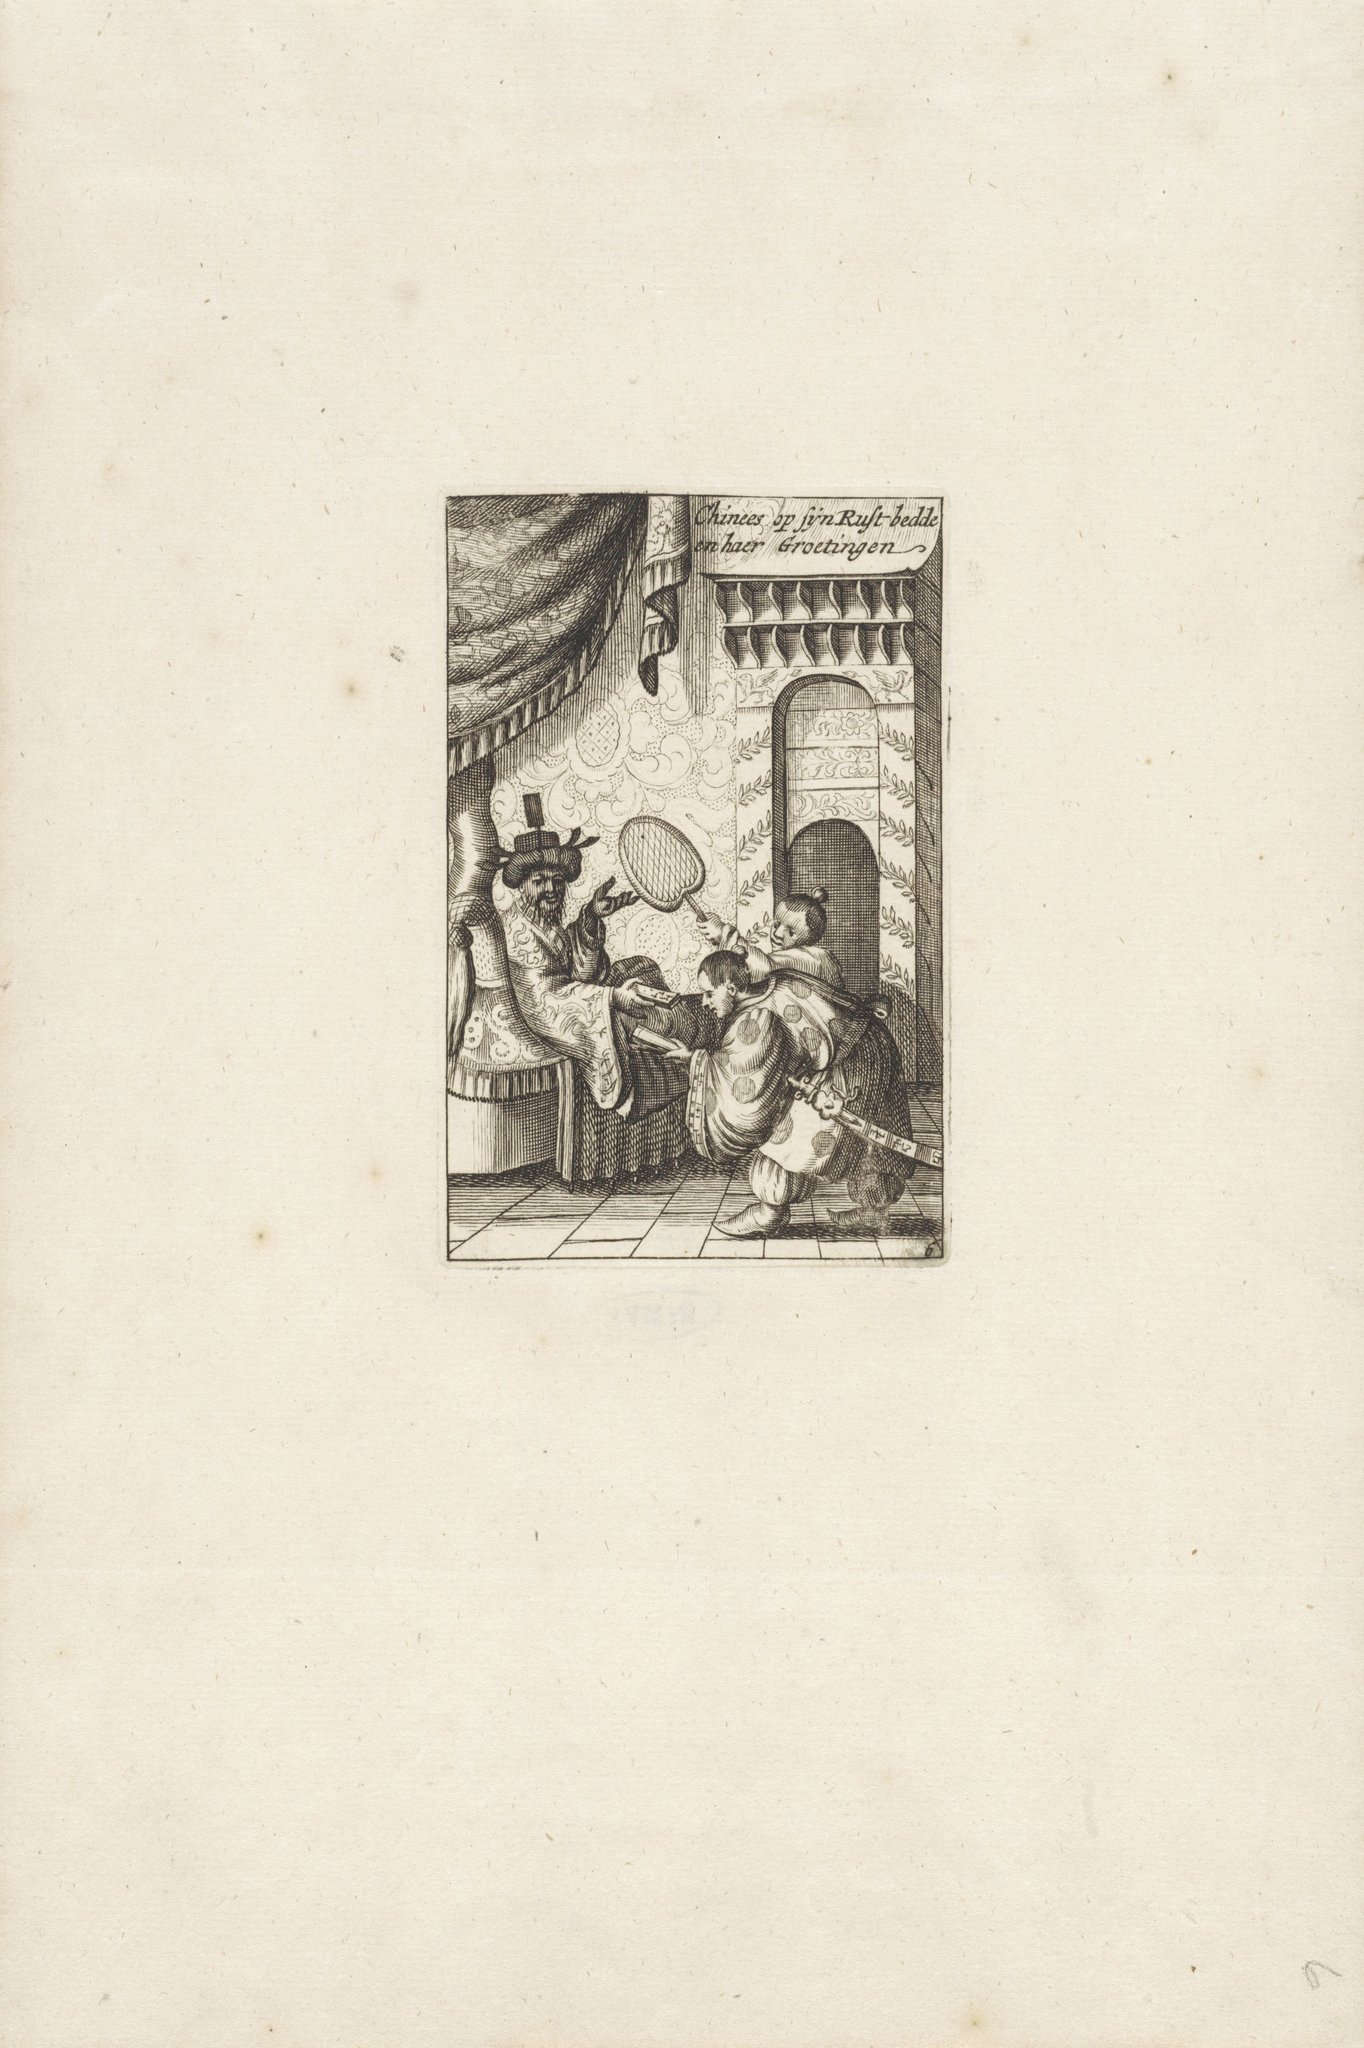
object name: print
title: Chinees op sijn Rust bedde en haer Groetingen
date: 1682-1711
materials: paper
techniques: etching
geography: amsterdam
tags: chinese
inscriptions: collector's mark: Lugt 2228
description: Deze serie bestaat uit kopieën naar de prenten in: Vries, Simon de. Curieuse aenmerckingen der bysonderste Oost en West-Indische verwonderens-waerdige dingen. Utrecht: Johannes Ribbius, 1682.